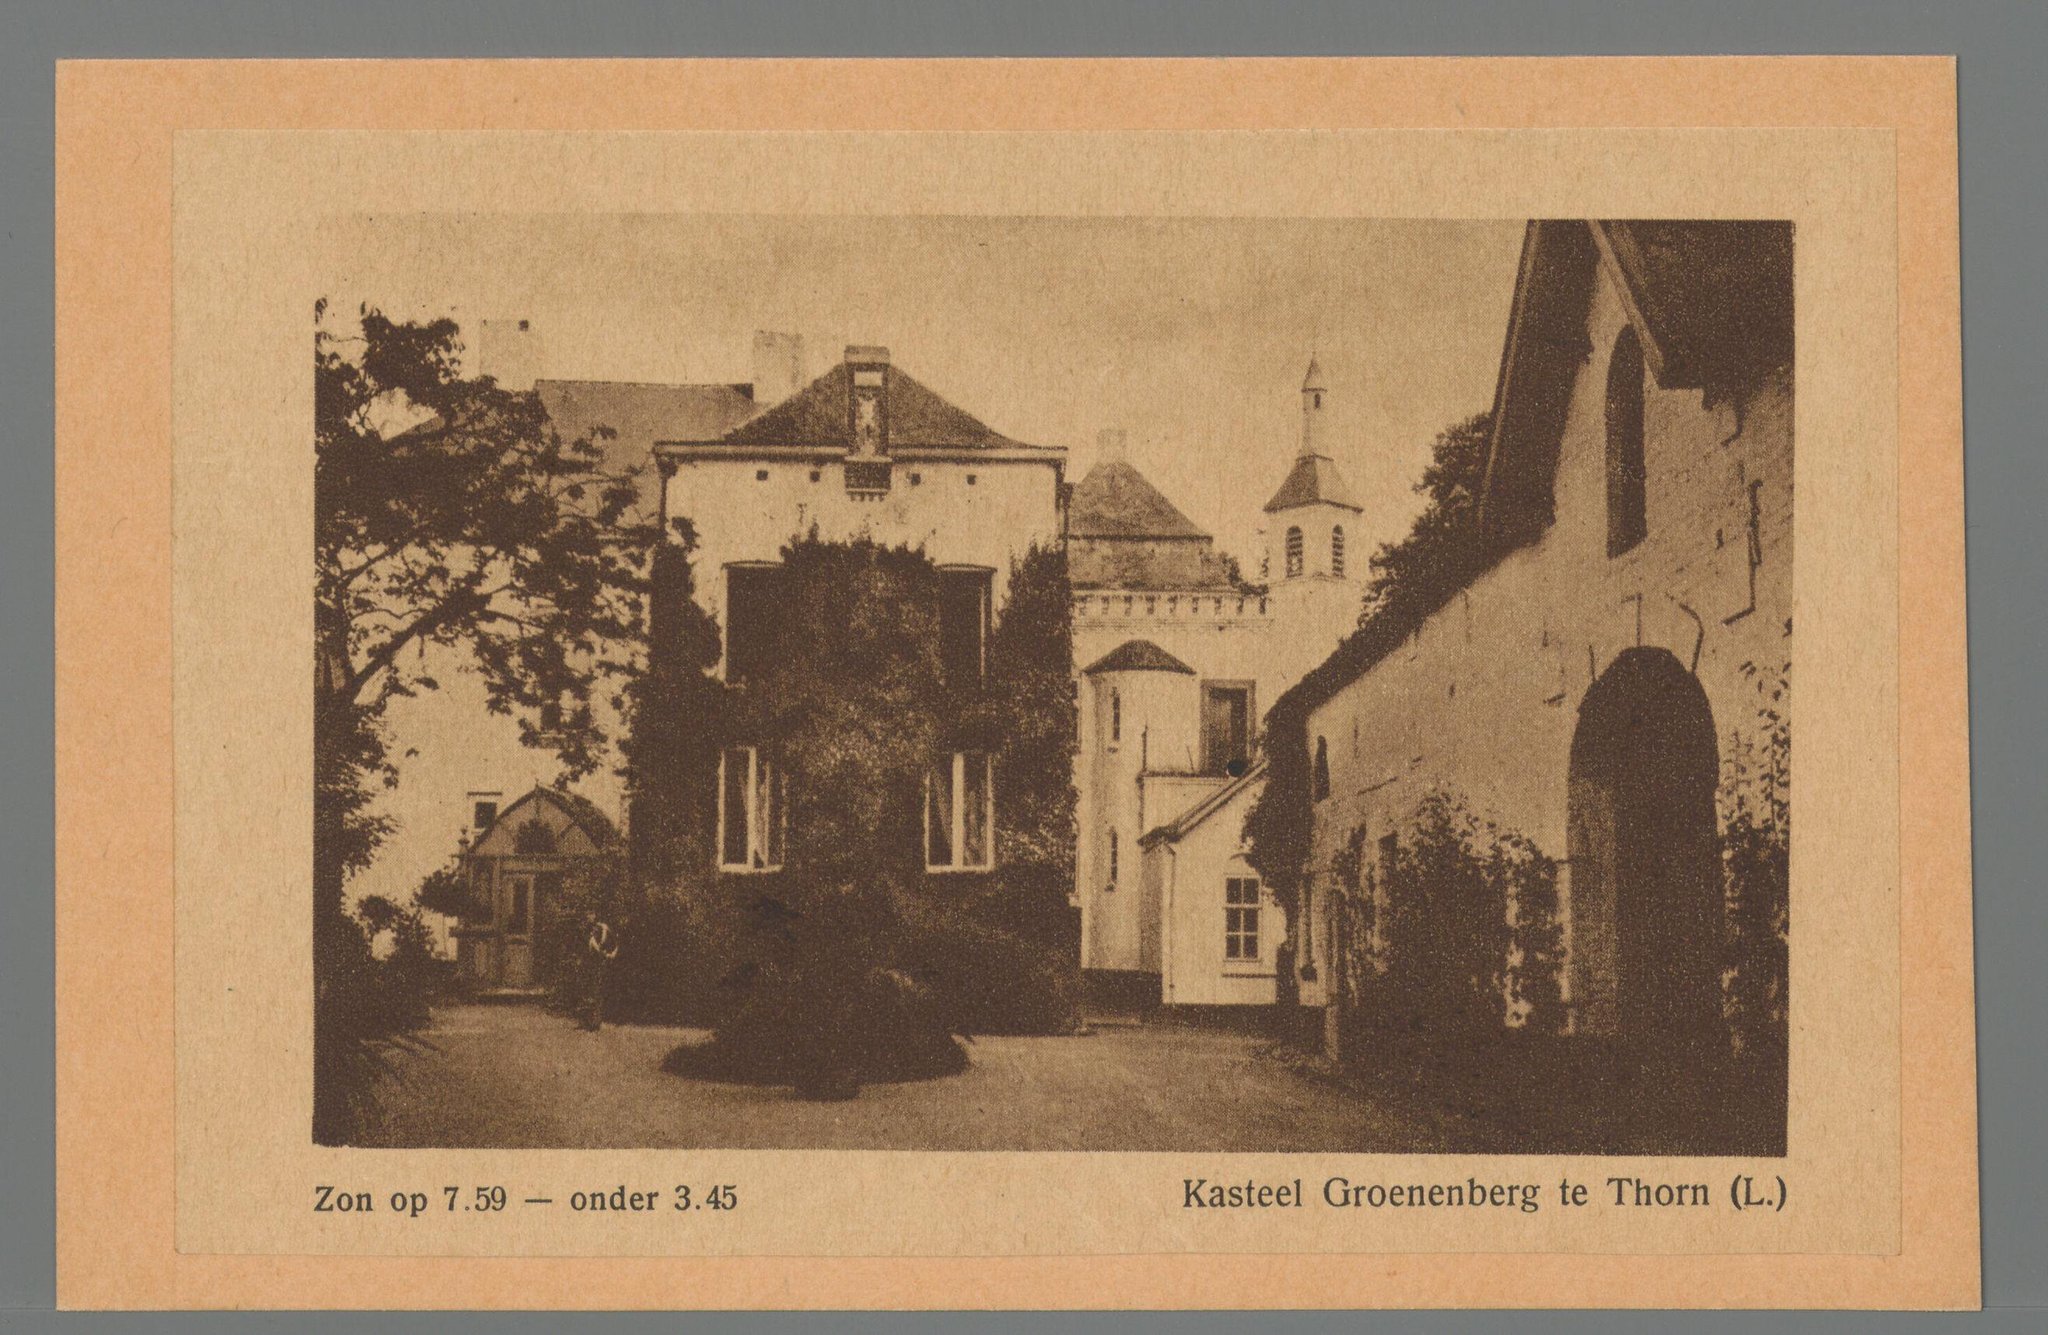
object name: ansichtkaart, prentbriefkaart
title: Kasteel Groenenberg te Thorn (L.)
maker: Anonymous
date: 1895-1930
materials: cardboard, paper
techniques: rotogravure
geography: thorn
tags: castle